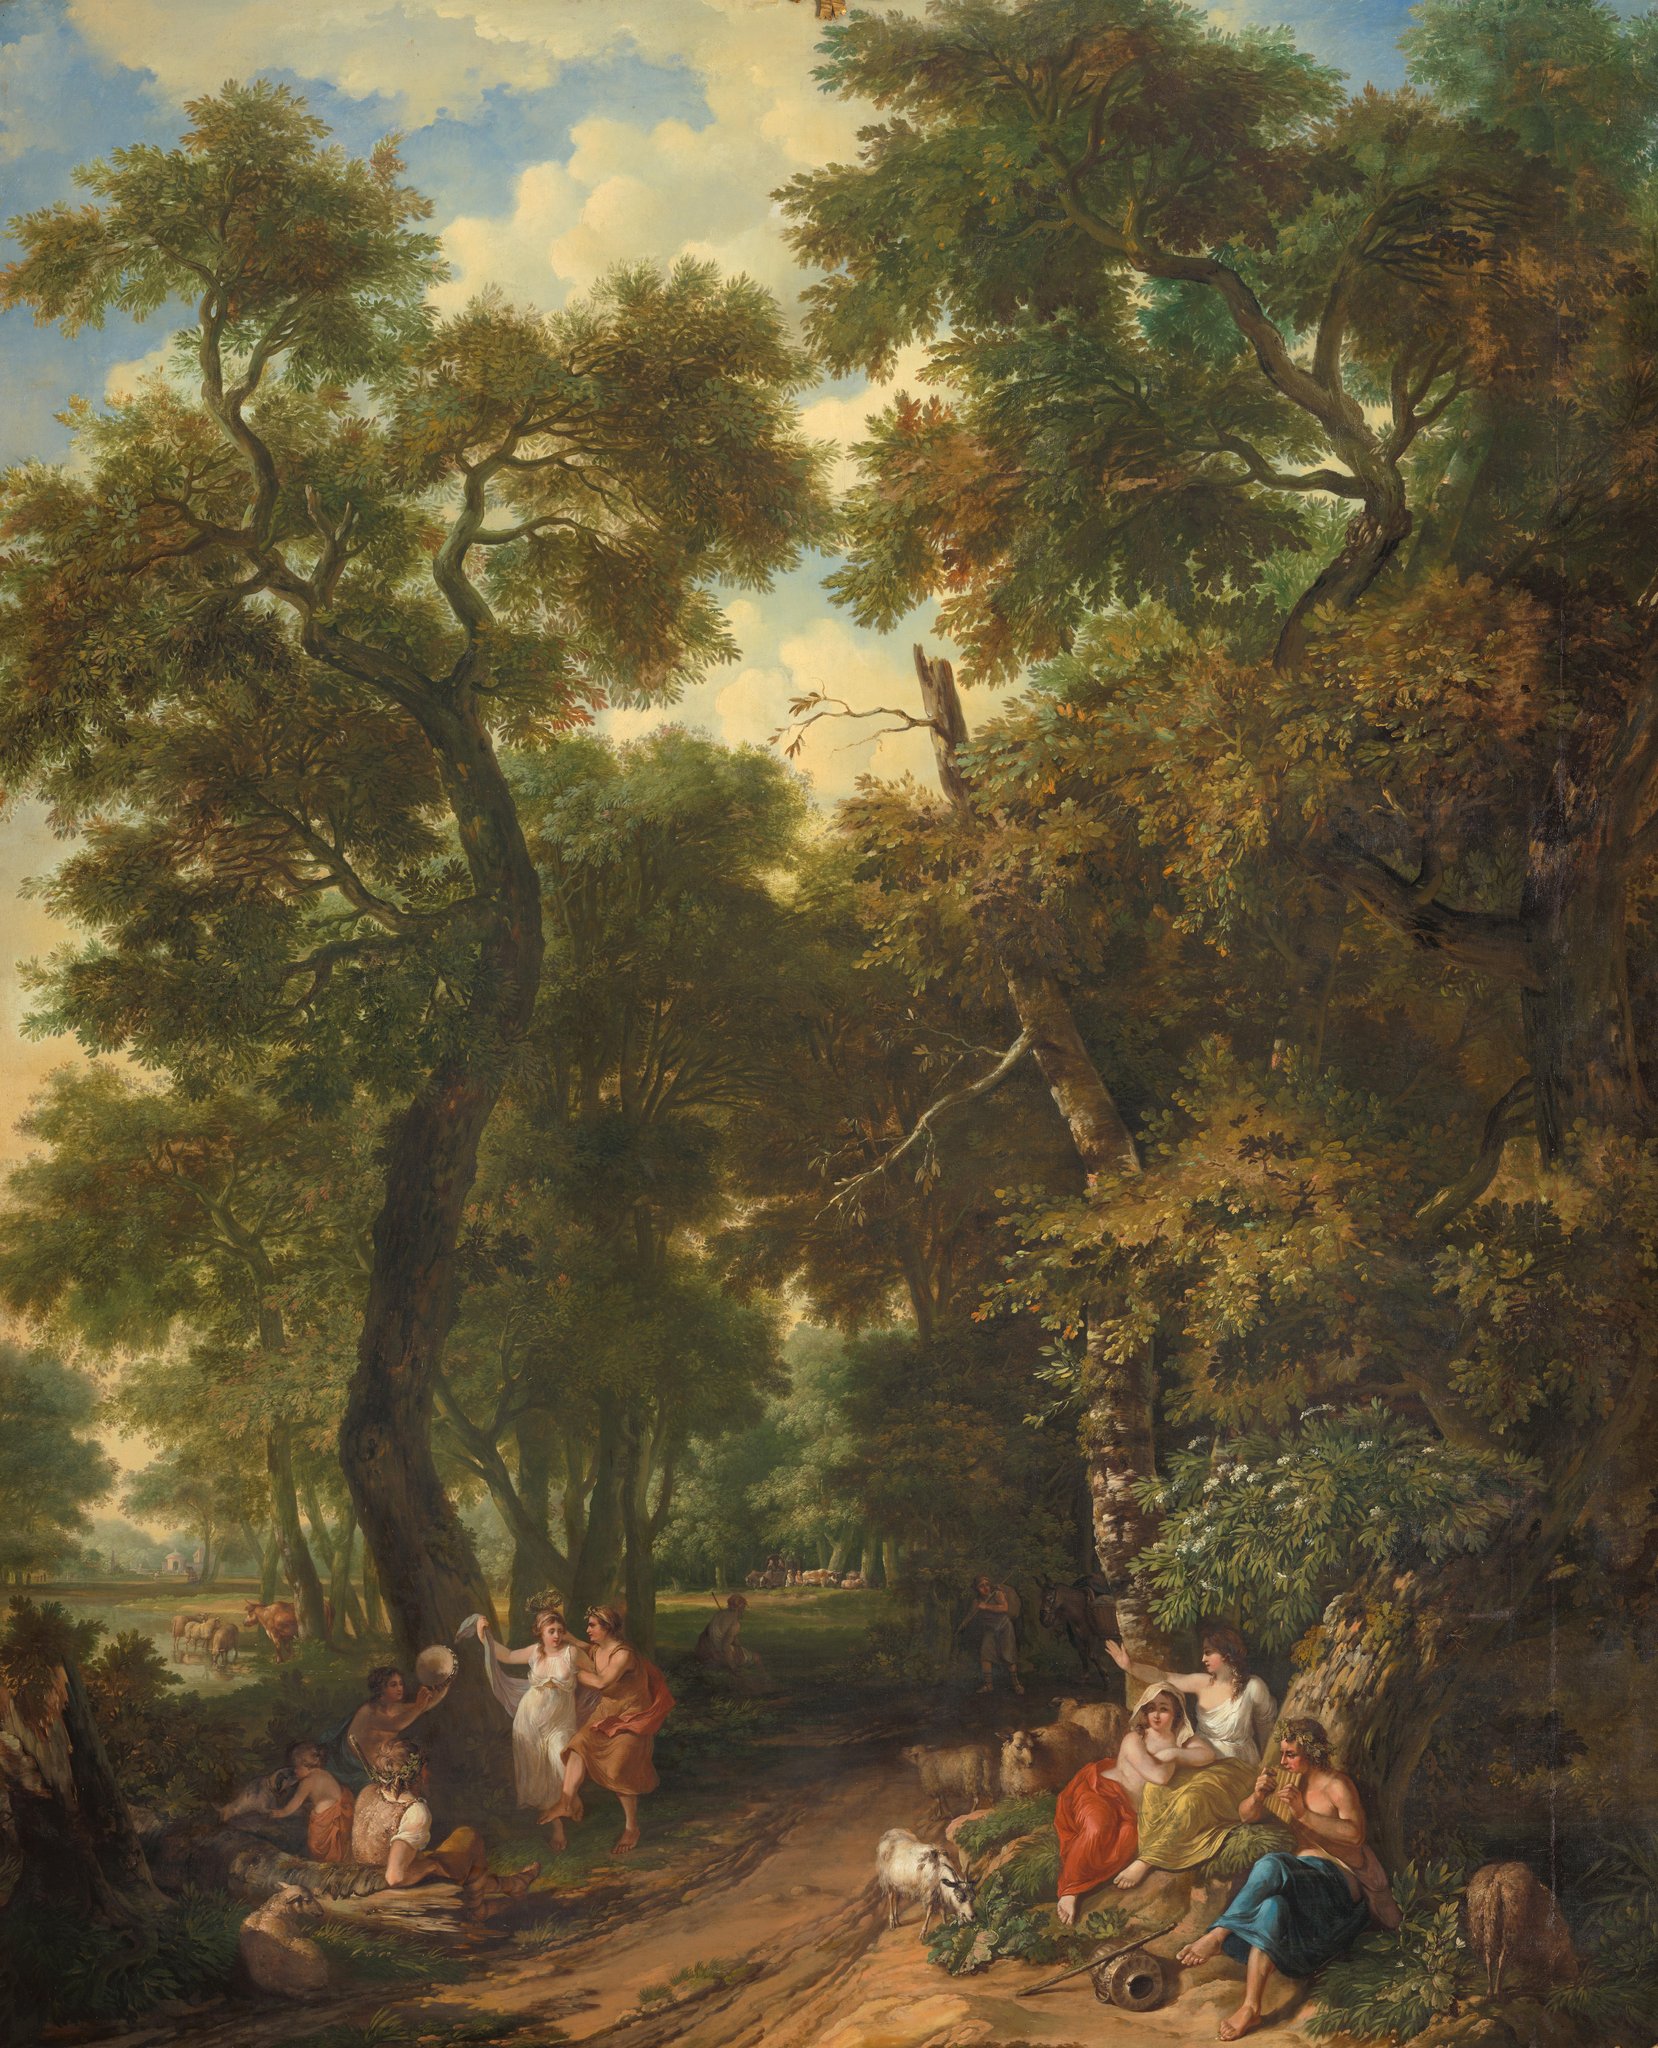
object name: mural painting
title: Arcadisch landschap met musicerende en dansende herders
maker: jurriaan andriessen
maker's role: draughtsman, painter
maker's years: 1742-1819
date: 1771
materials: canvas, oil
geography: amsterdam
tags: pastorals, arcadian scenes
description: Wandschildering links van de schoorsteenmantel. Uit een serie van tien wandschilderingen met arcadische landschappen in de kamer aan de tuinkant op de hoofdverdieping van het huis Herengracht 524 te Amsterdam.